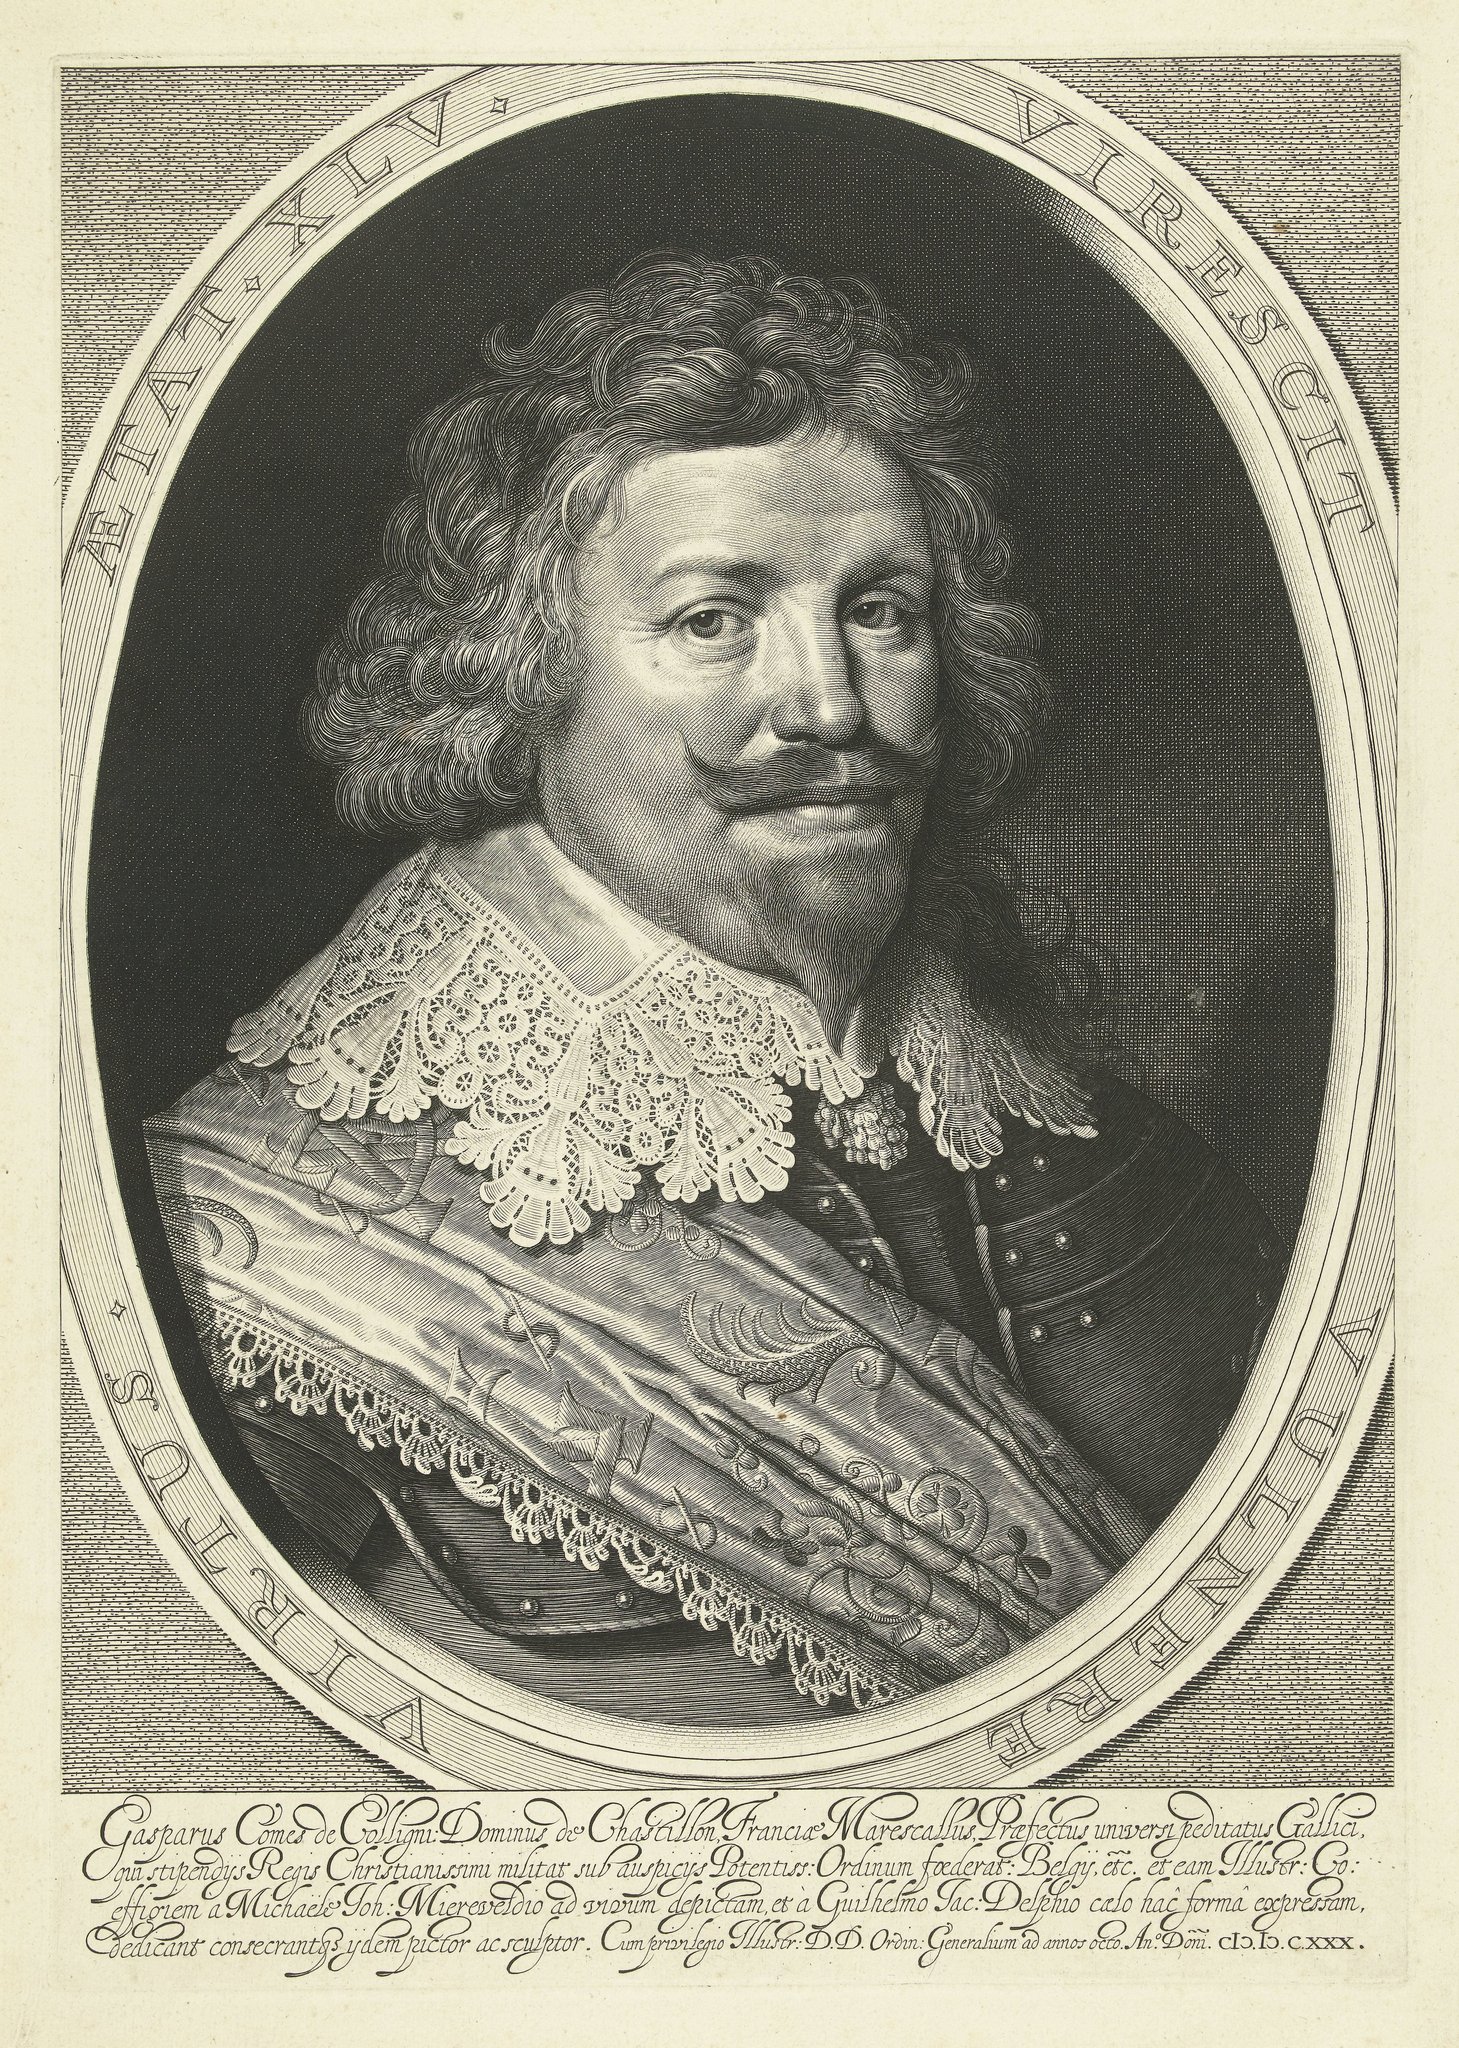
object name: print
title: Portret van Gaspard de Coligny, hertog van Châtillon op 45-jarige leeftijd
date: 1630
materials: paper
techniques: engraving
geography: delft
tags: commander-in-chief, general, marshal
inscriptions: collector's mark: Lugt 2228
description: Portret van Gaspard de Coligny, hertog van Châtillon op 45-jarige leeftijd, borststuk in harnas met kanten kraag in ovale omlijsting met motto. In ondermarge vier regels Latijns opschrift.